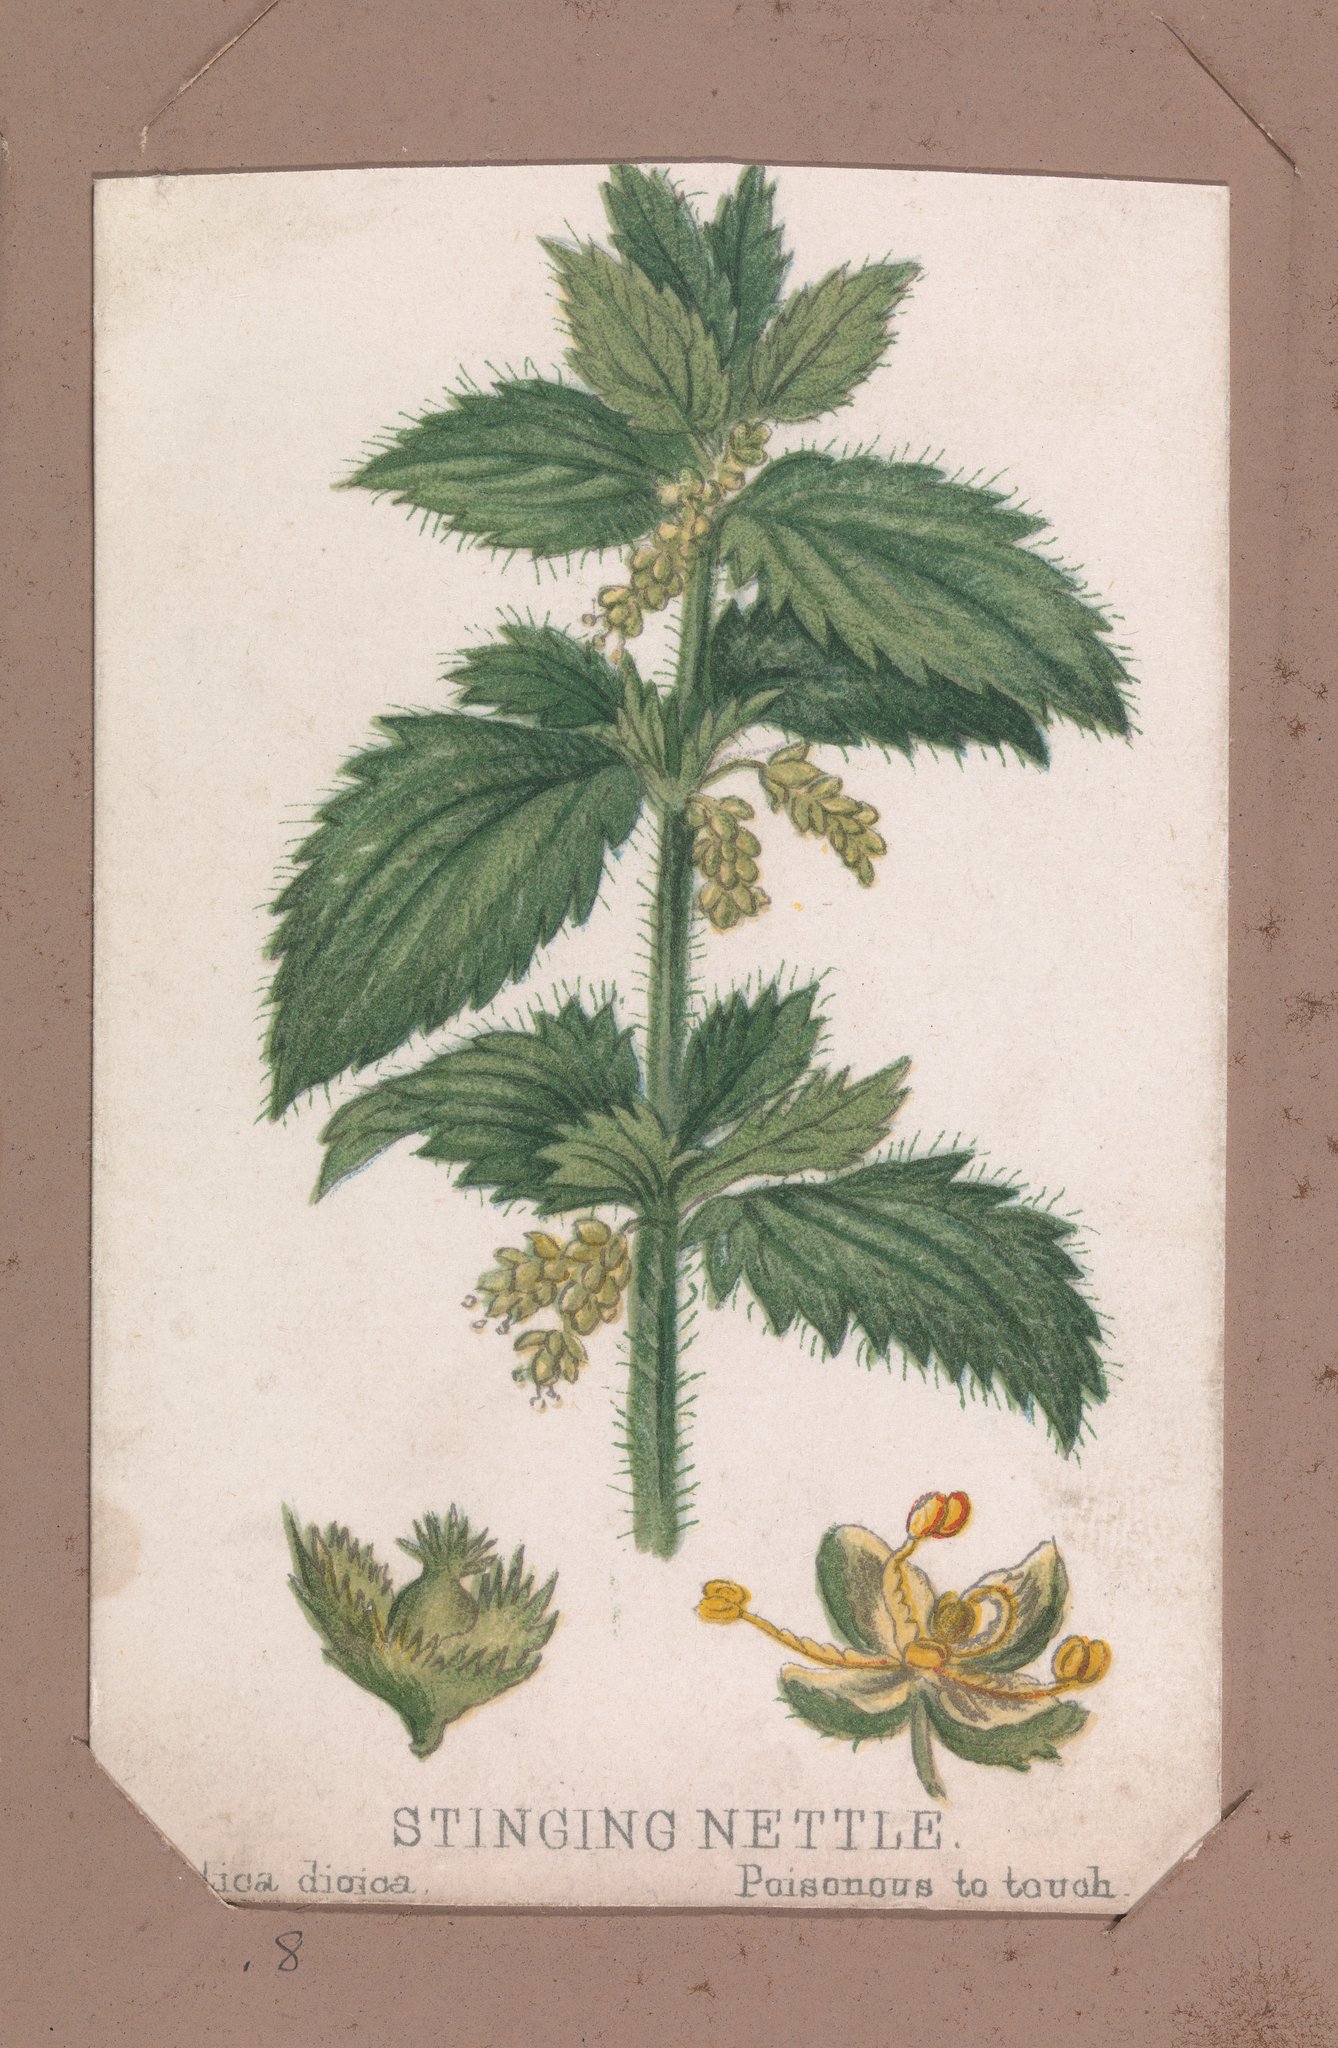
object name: album card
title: Stinging Nettle from the Plants series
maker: louis prang & co.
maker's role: publisher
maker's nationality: american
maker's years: 1800-1950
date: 1862-1869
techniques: lithograph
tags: plants